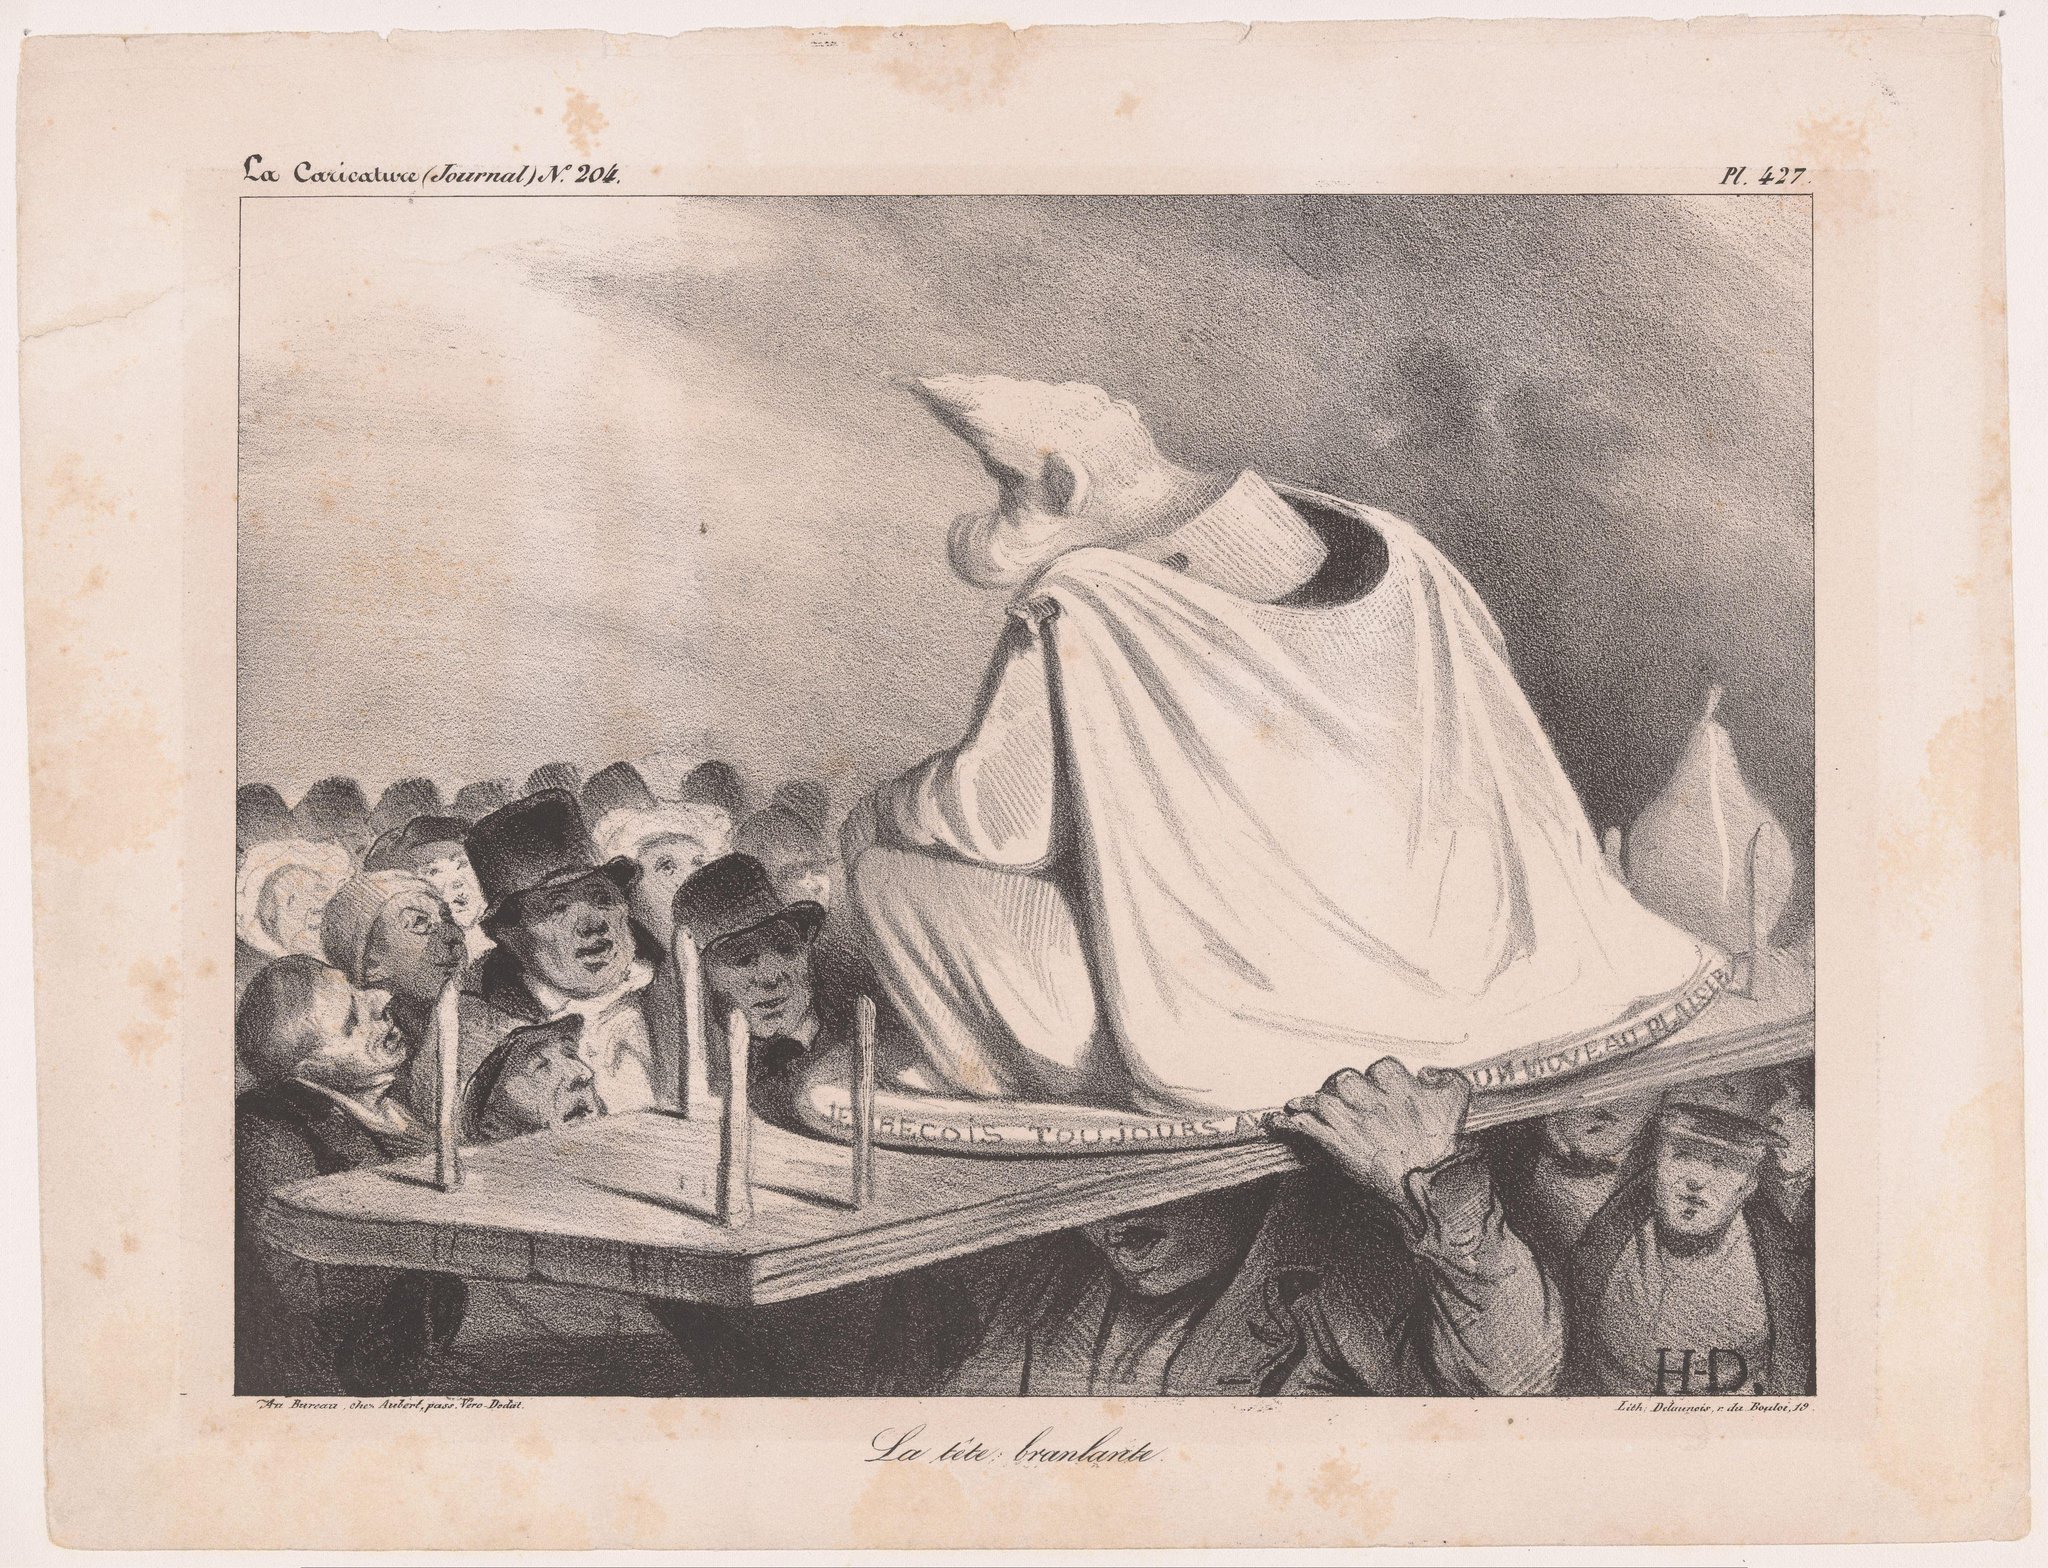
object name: print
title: Karikatuur van Lodewijk Filips I, koning van Frankrijk als gipsen beeld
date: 1834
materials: paper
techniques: lithograph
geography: paris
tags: paris, lodewijk filips i (koning van frankrijk), caricatures (human types), historical persons, sculpture, political caricatures and satires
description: Prent gepubliceerd in: La Caricature, 2 oktober 1834, nr. 204, pl. 427.